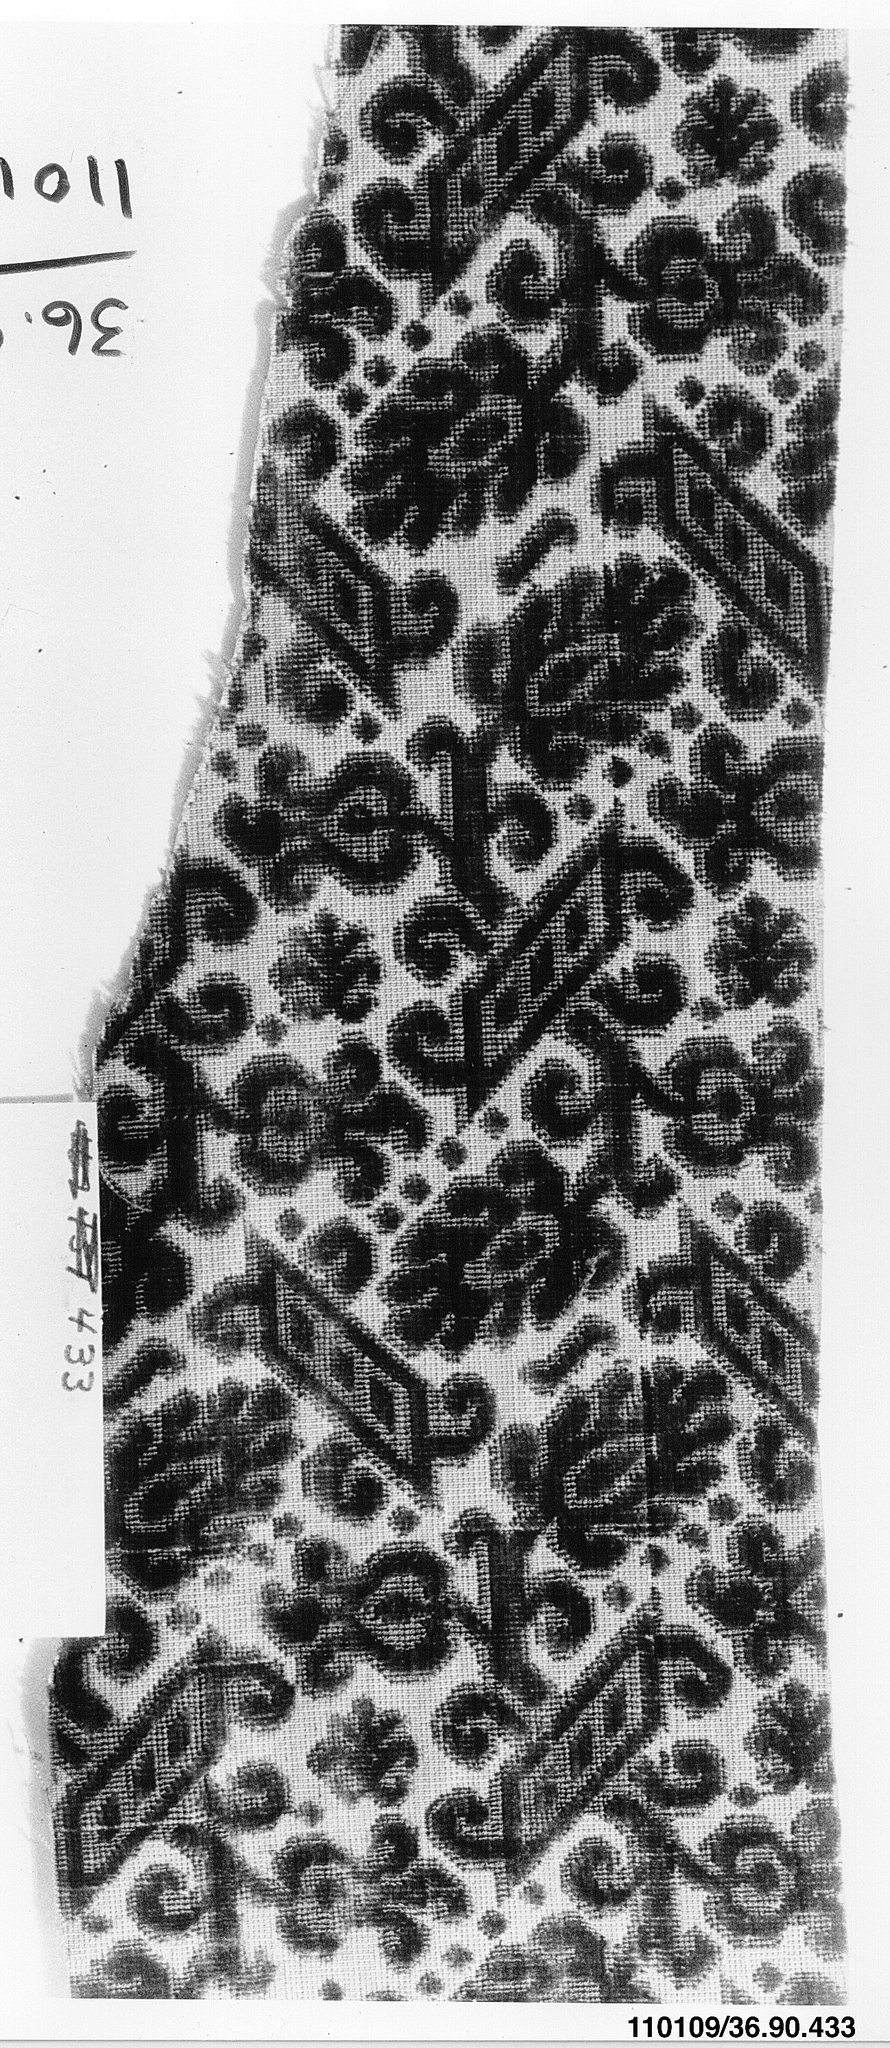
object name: piece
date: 1501-1700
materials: silk